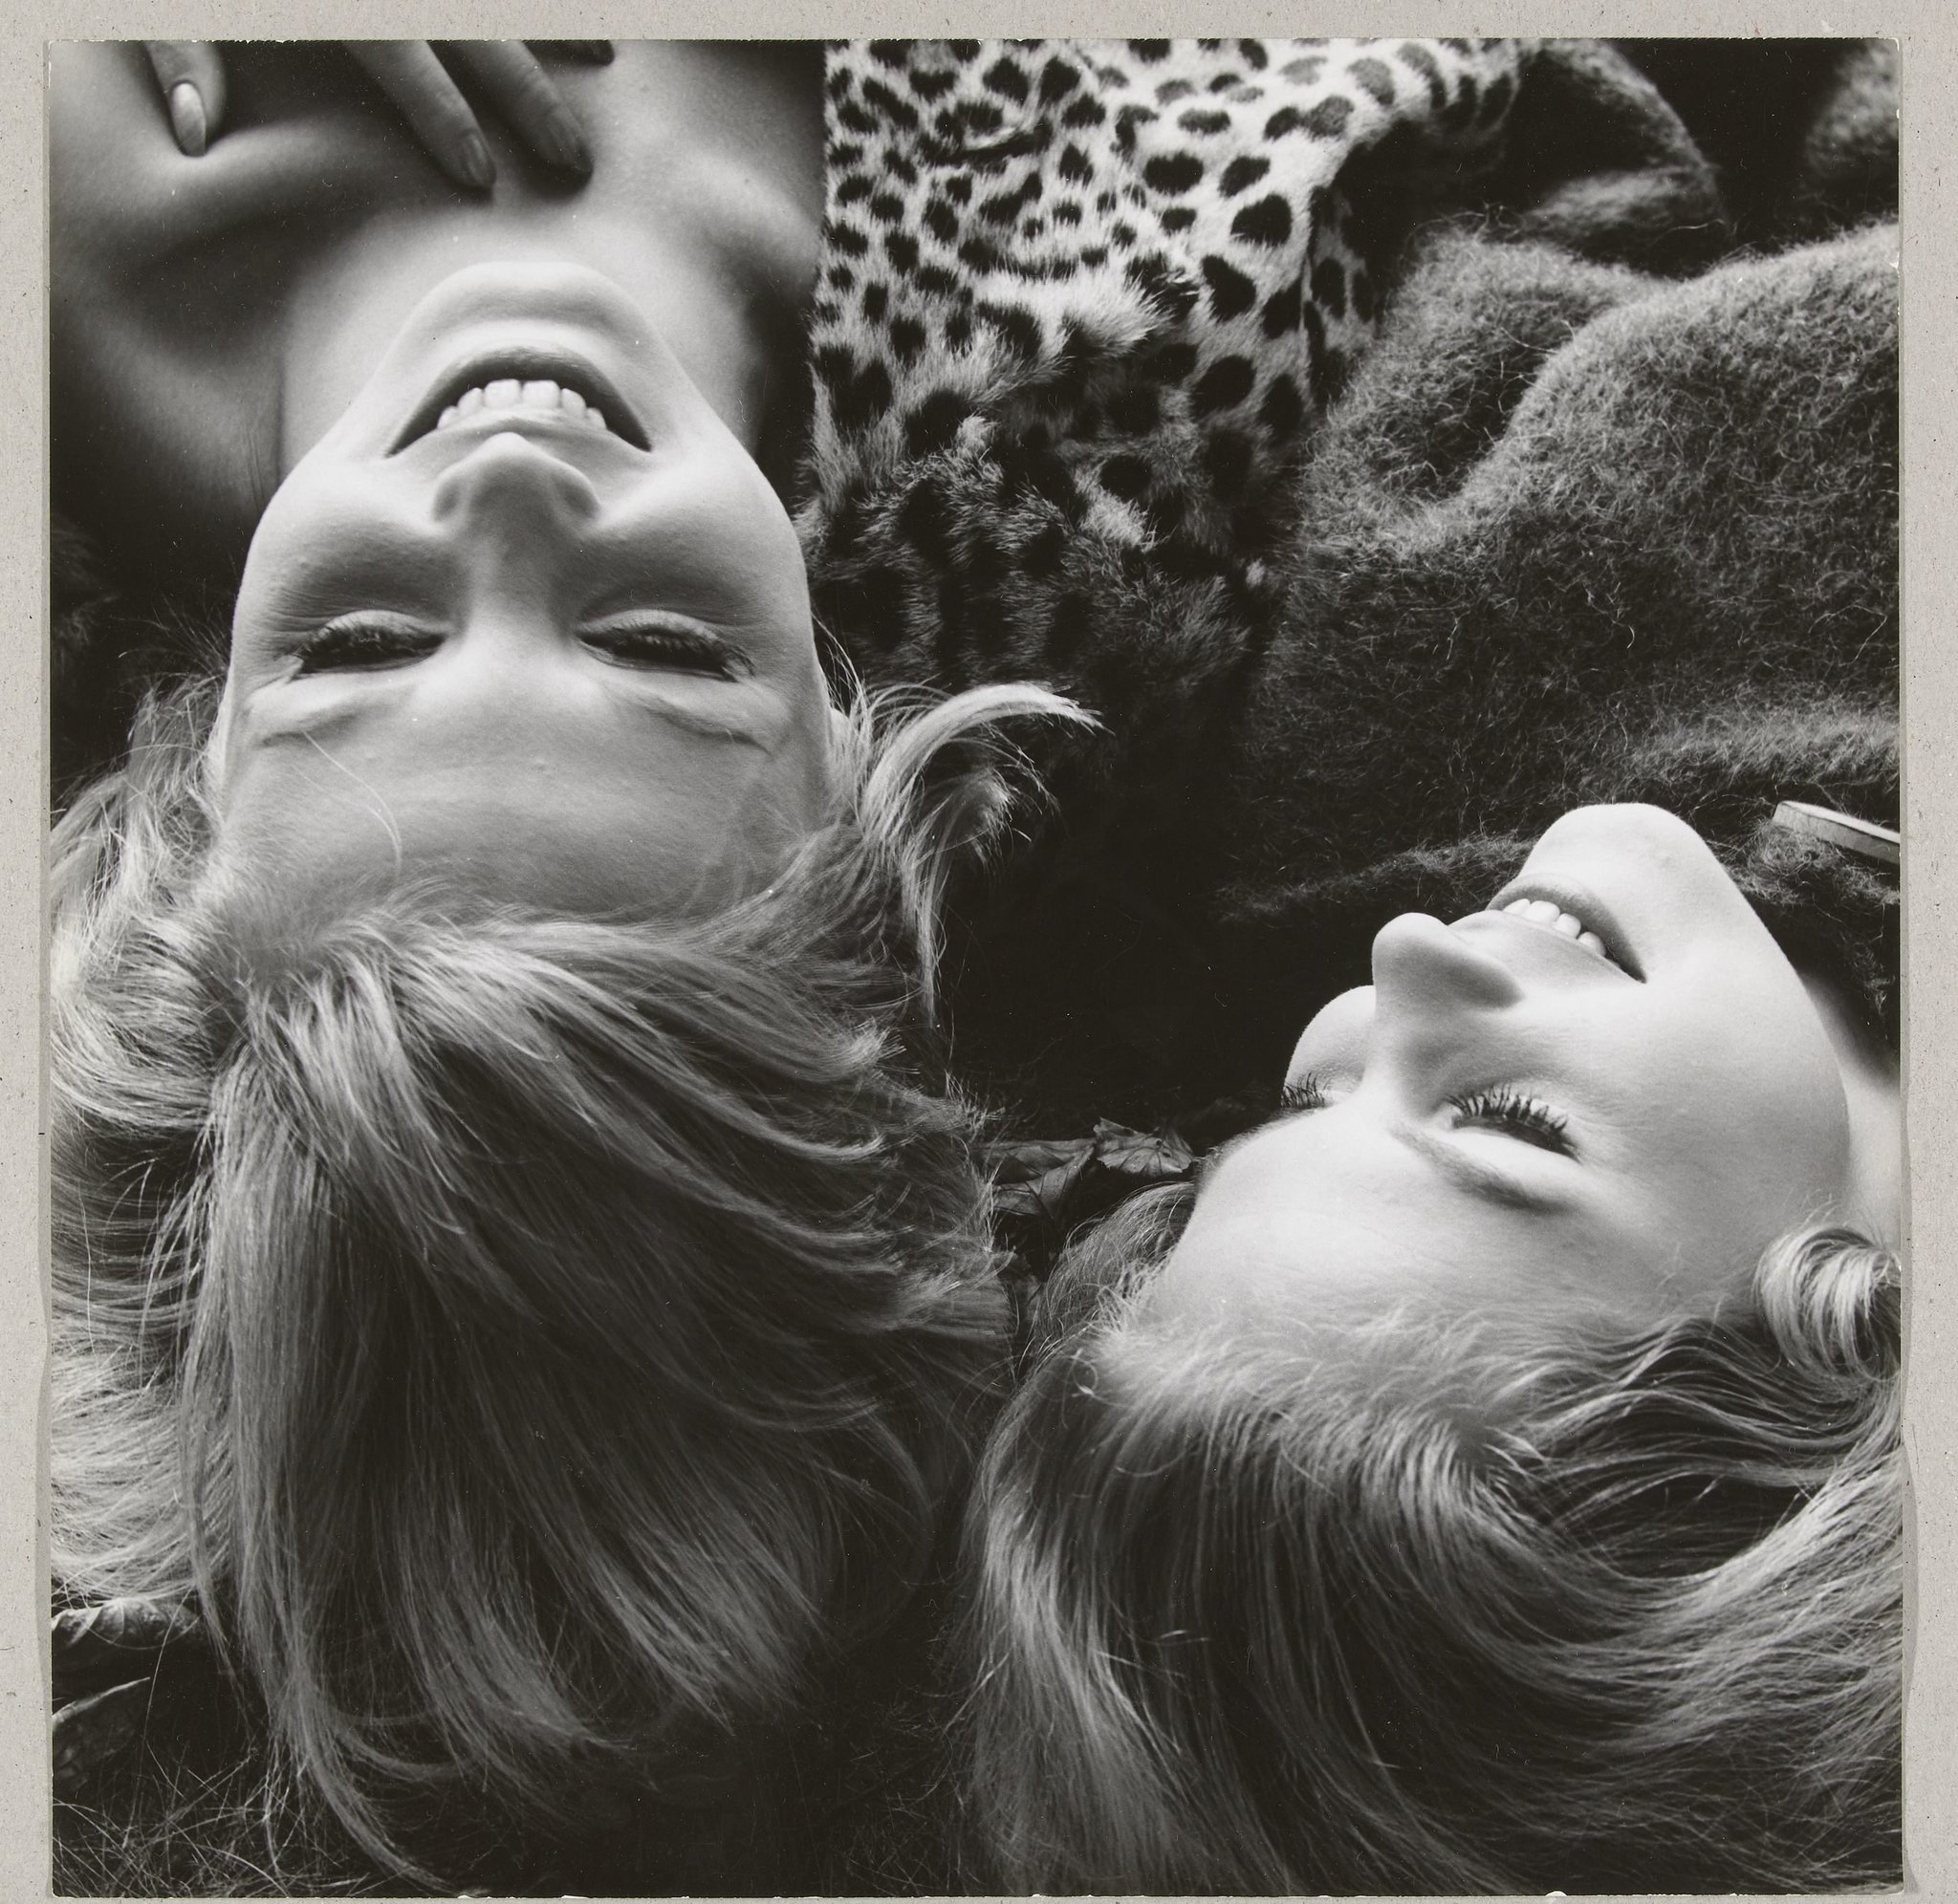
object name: photograph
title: Portret van Tine Kleiterp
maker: Anonymous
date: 1925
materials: cardboard, photographic support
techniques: gelatin silver print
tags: head-gear: hat (+ women's clothes)